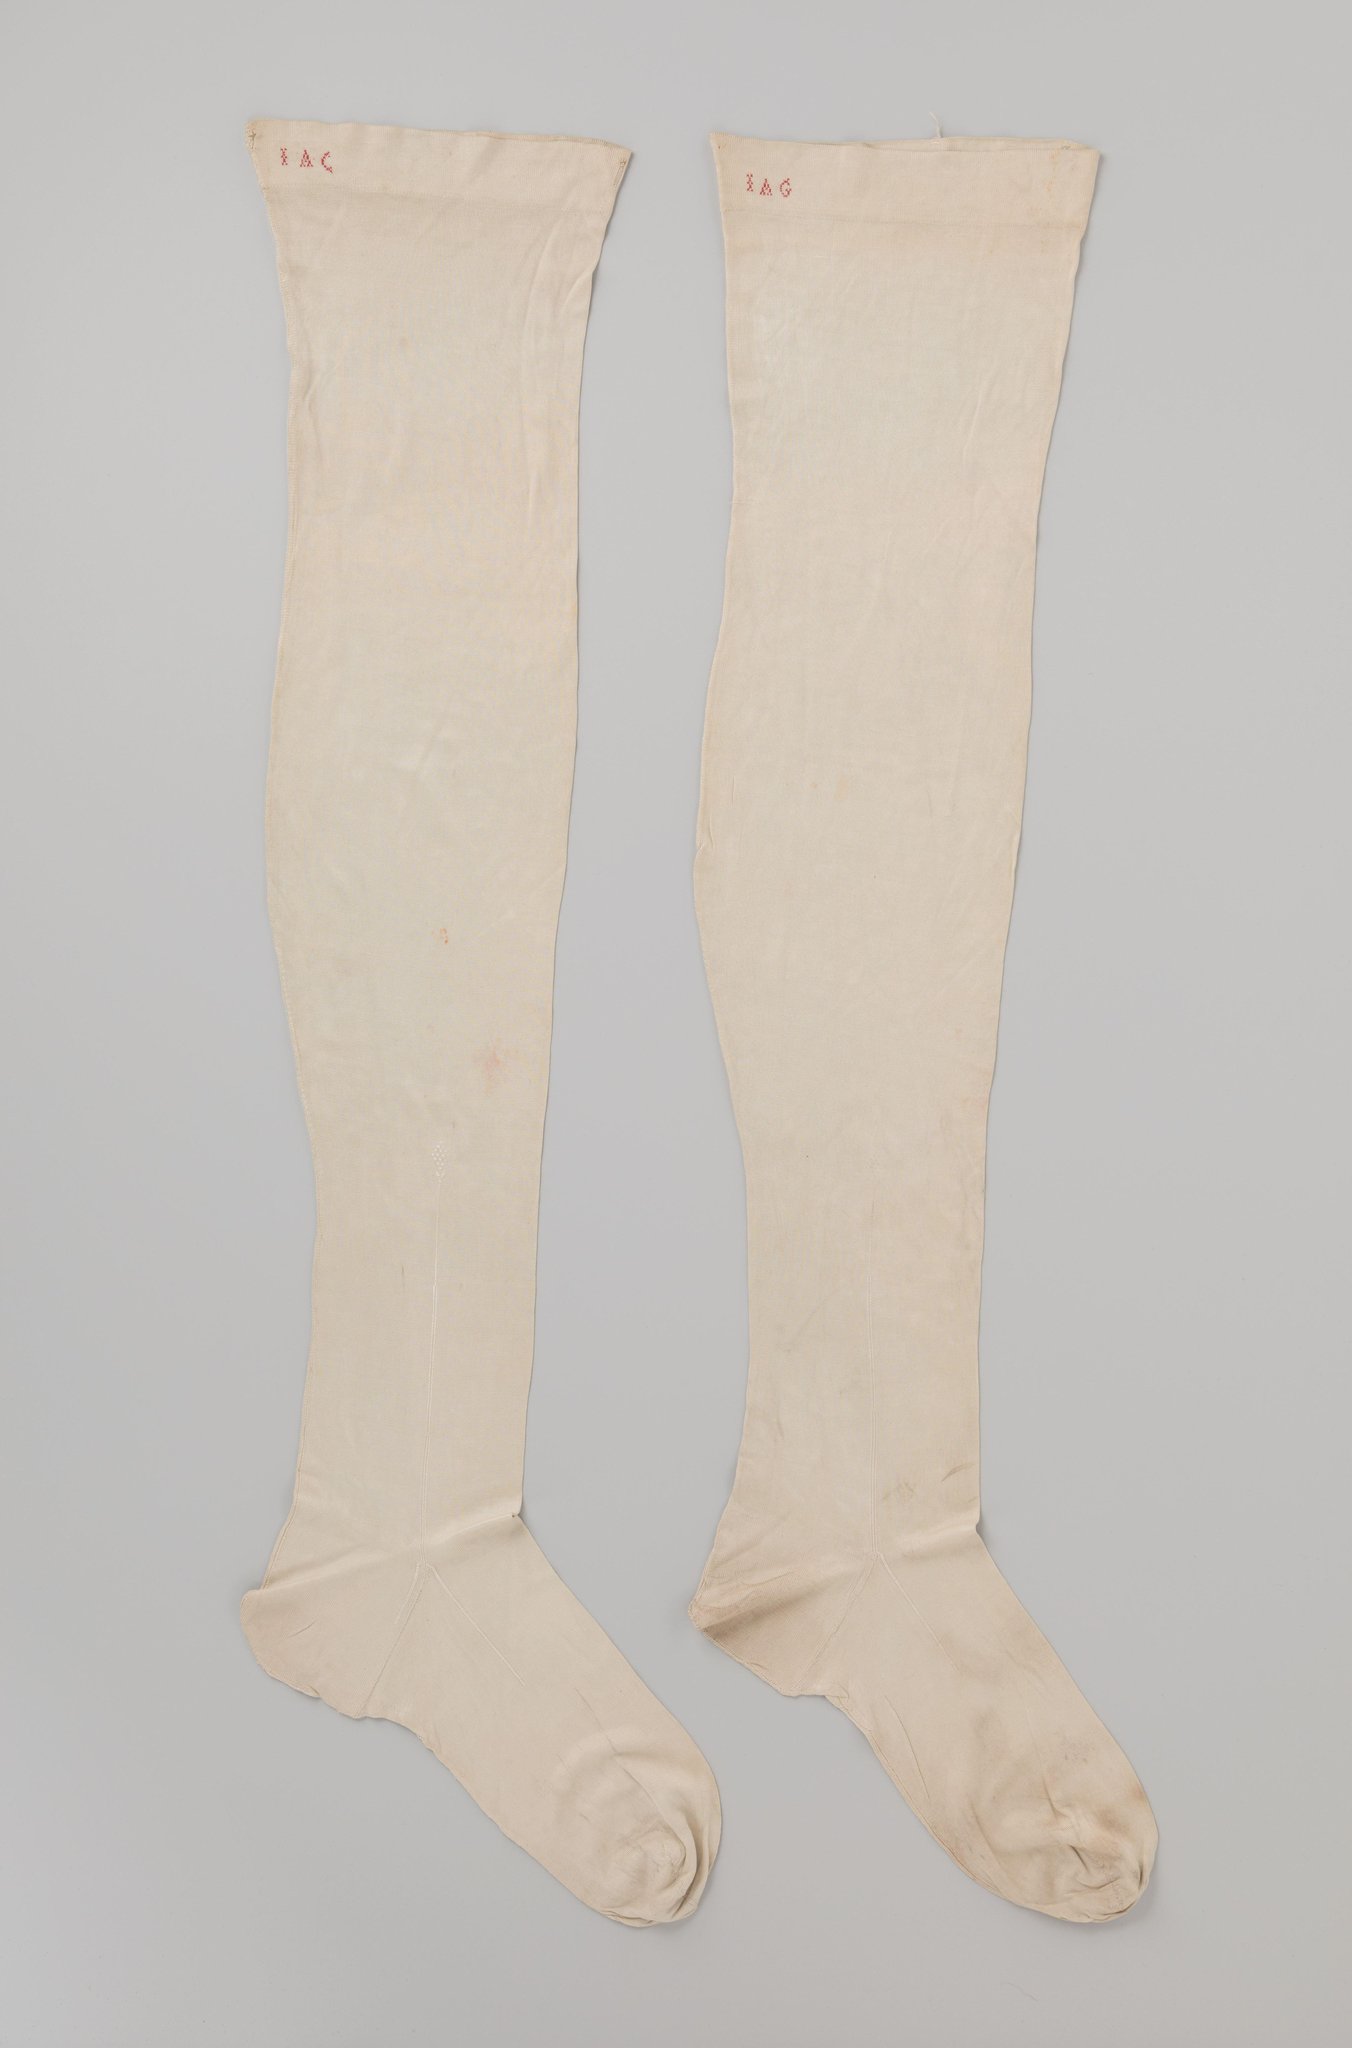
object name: clothing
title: Kous van witte zijde met op de klink een geborduurde lijn, eindigend in een diamantvorm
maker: Anonymous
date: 1800-1820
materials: silk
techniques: cross stitching, knitting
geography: netherlands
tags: vught, overveen, minister, staatsman, intendant-generaal van financien, secretaris van staat voor financien, minister van financiën, izaak jean alexandre gogel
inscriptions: initials: ‘'I.A.C.'’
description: Kous van witte zijde met op de klink een geborduurde lijn, eindigend in een diamantvorm. Naad middenachter. Smal boord. Met rood kruissteek gemerkt 'I.A.C.'.